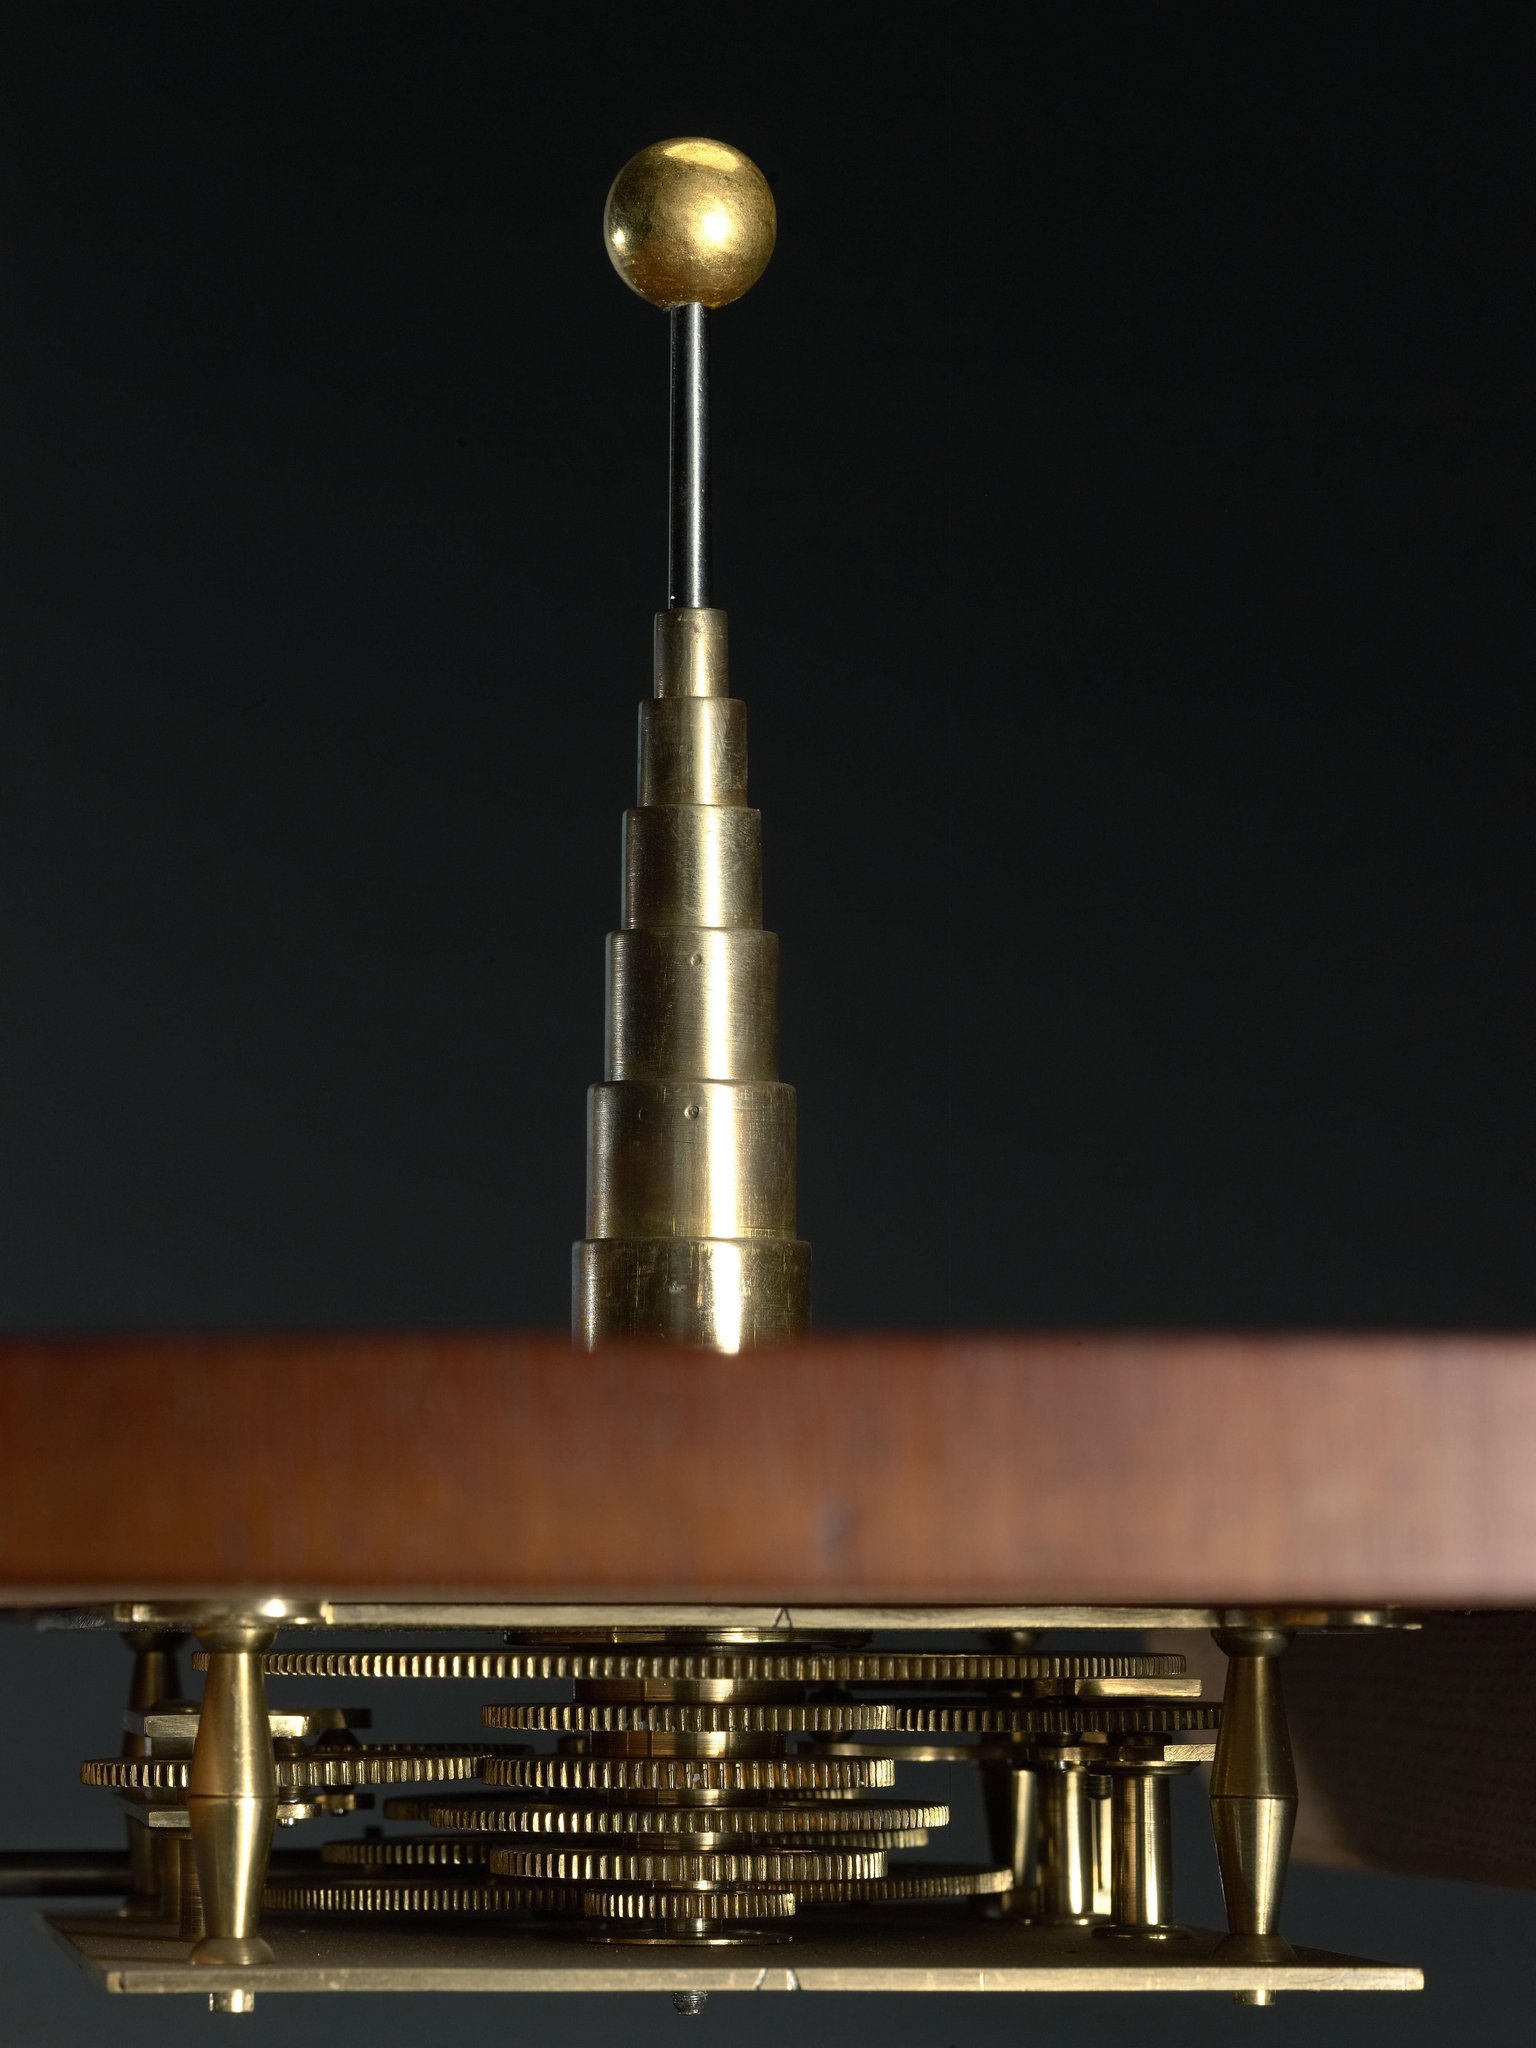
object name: lunarium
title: De zon, onderdeel van het planetarium, tellurium, lunarium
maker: hartog van laun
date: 1800-1808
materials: brass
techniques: gilding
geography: amsterdam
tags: amsterdam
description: Toestel waarmee de beweging van zon, aarde, maan en planeten aanschouwelijk kan worden voorgesteld. Een vergulde bol op een trapsgewijze statief stelt de zon voor. De zon is niet origineel, maar in een reconstructie uit de jaren zeventig van de twintigste eeuw.